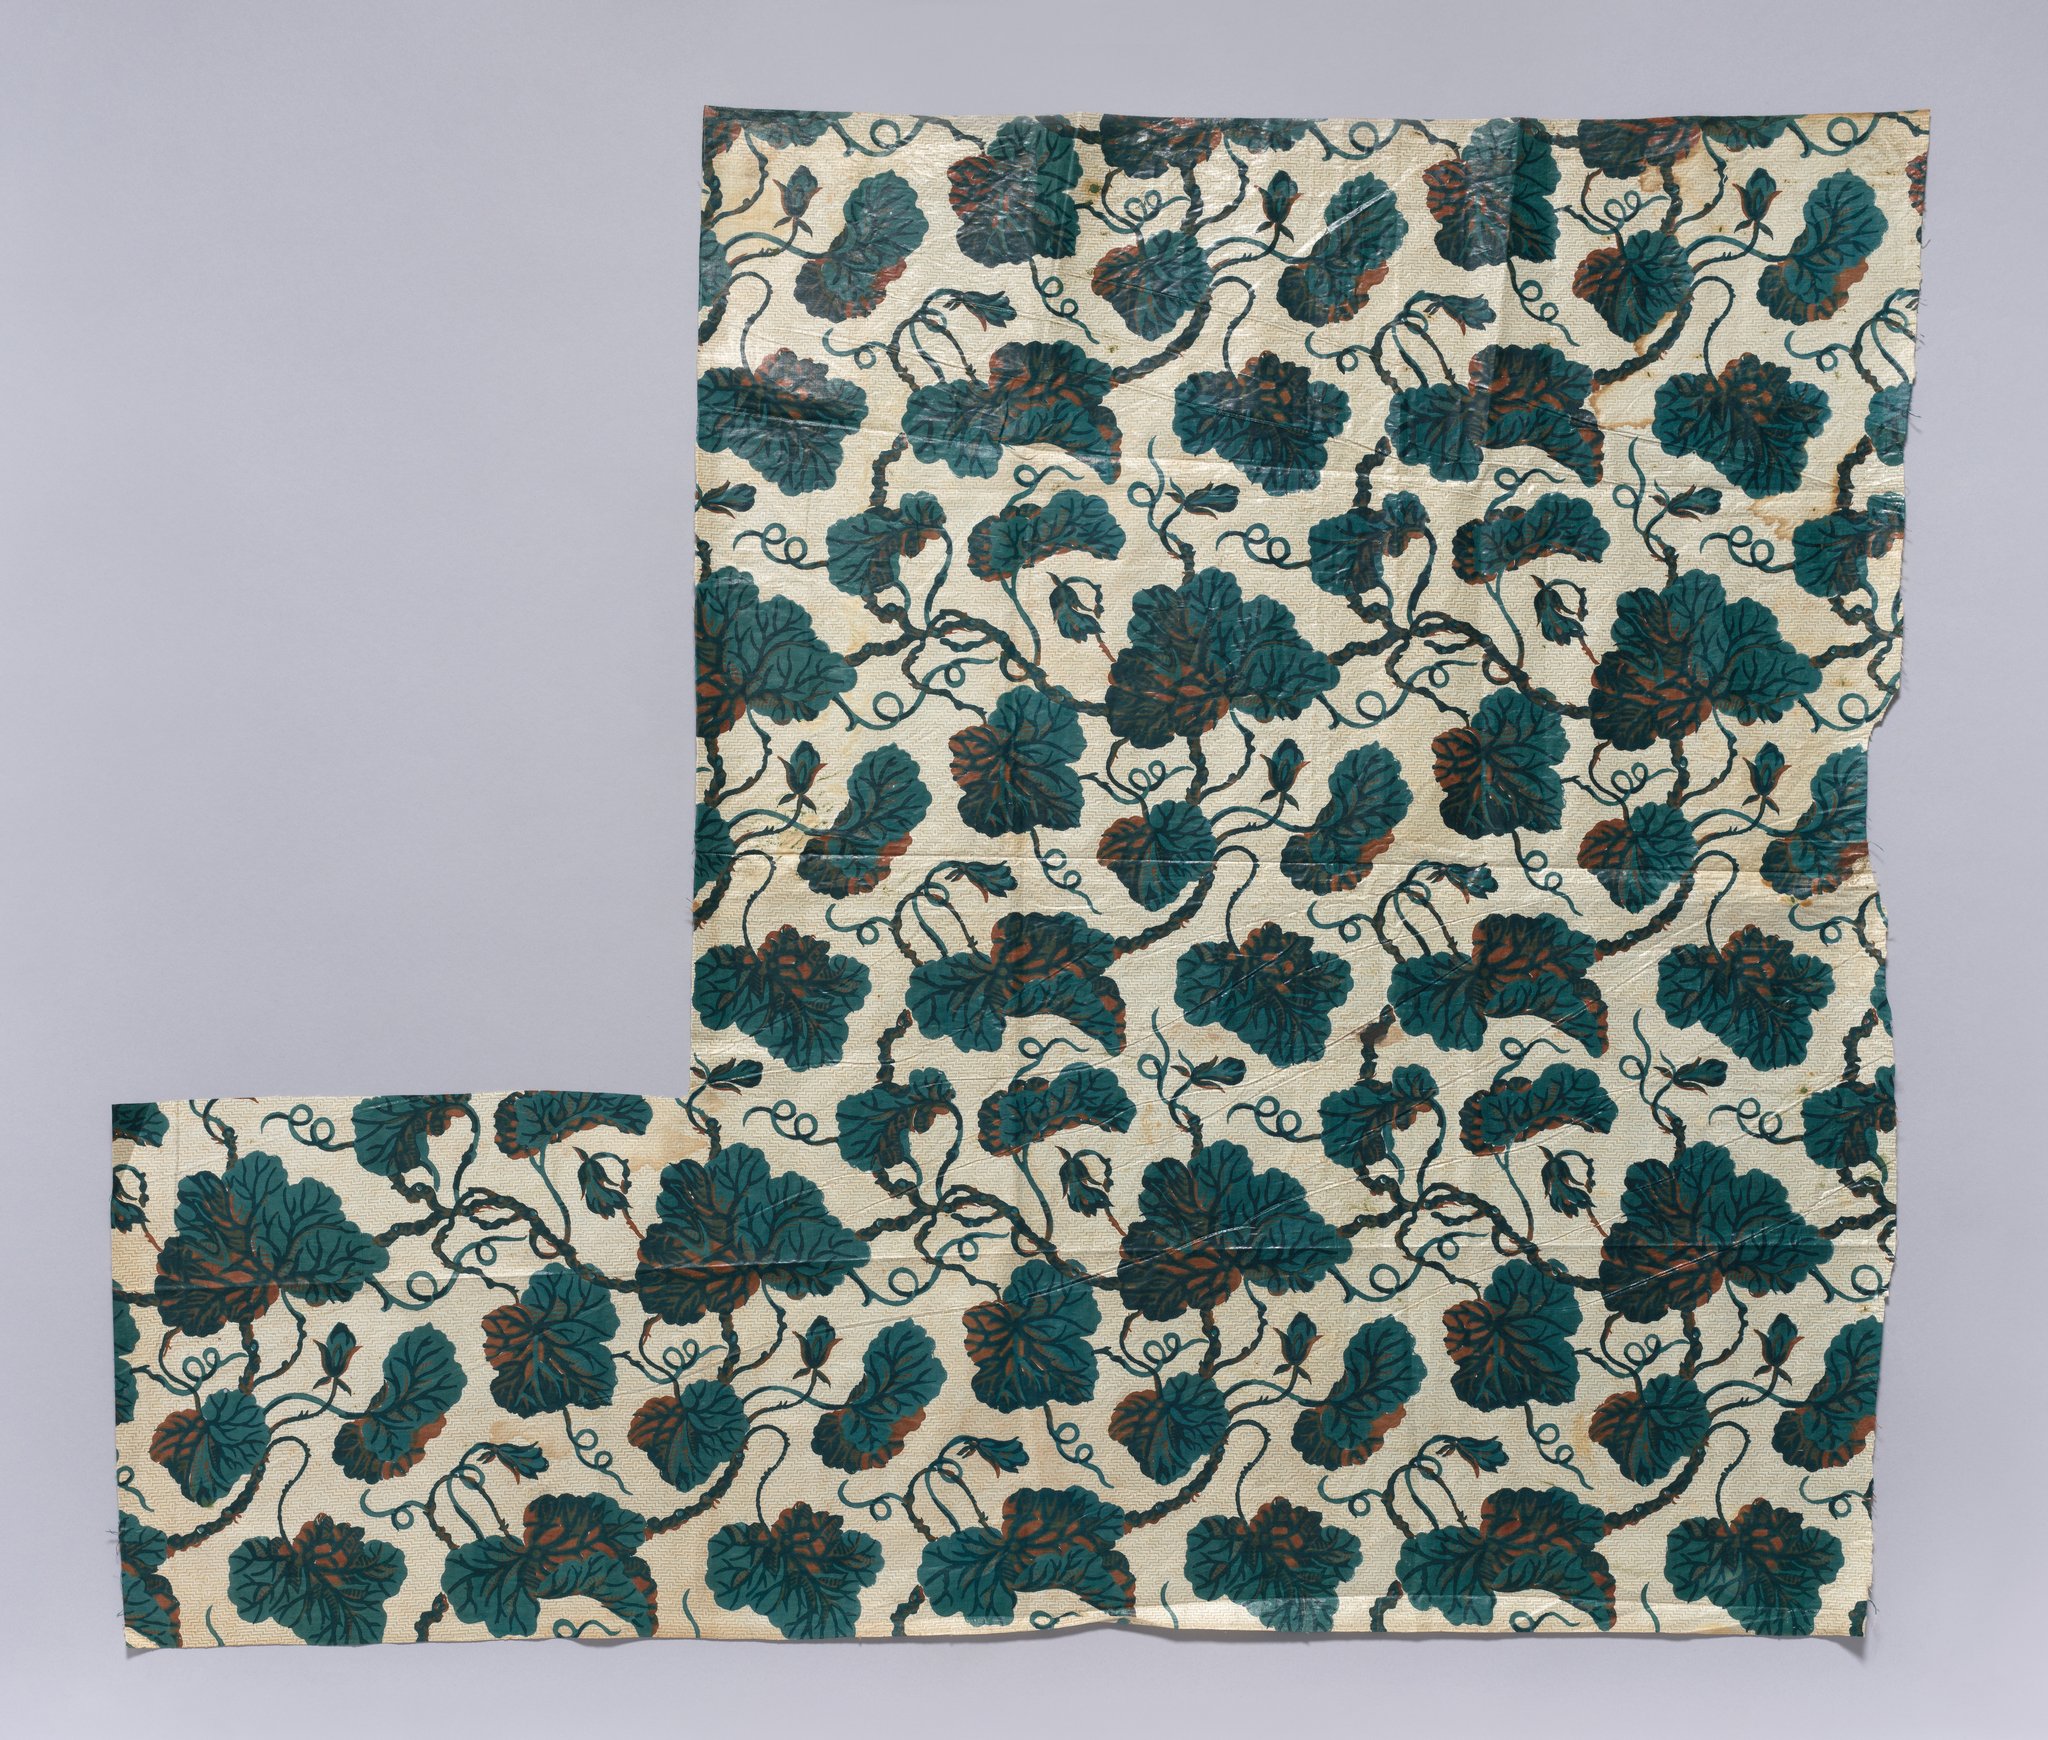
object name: length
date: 1825-1850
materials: cotton